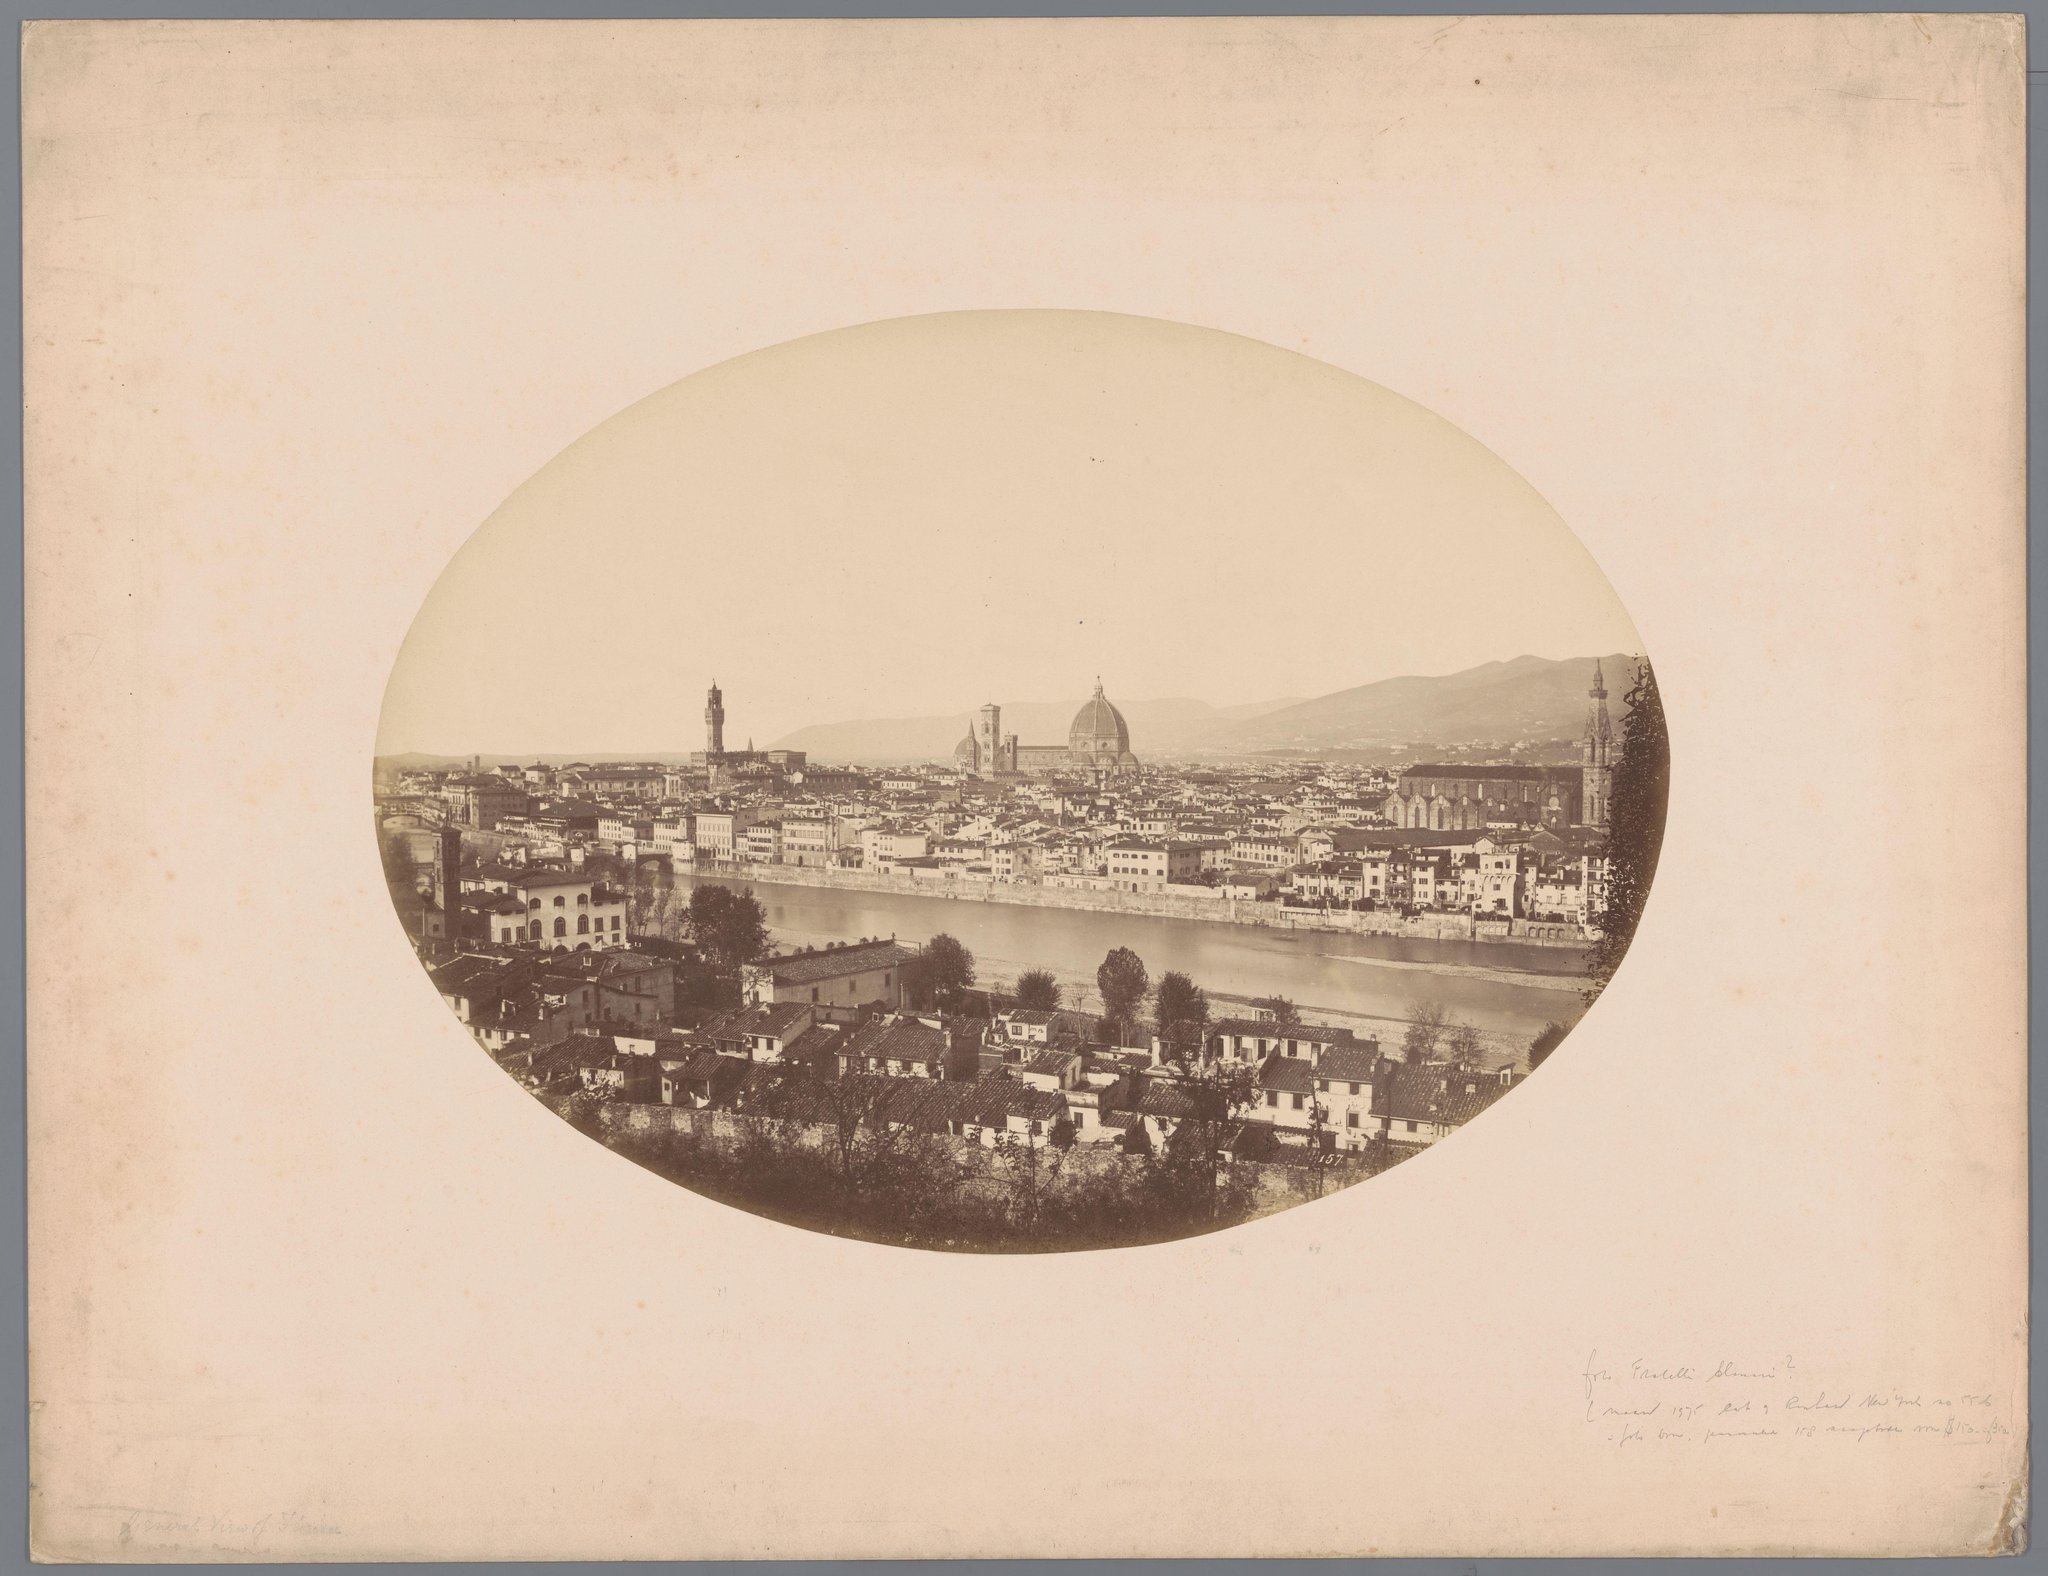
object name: photograph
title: Panorama op Florence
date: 1865-1890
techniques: albumen print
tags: florence